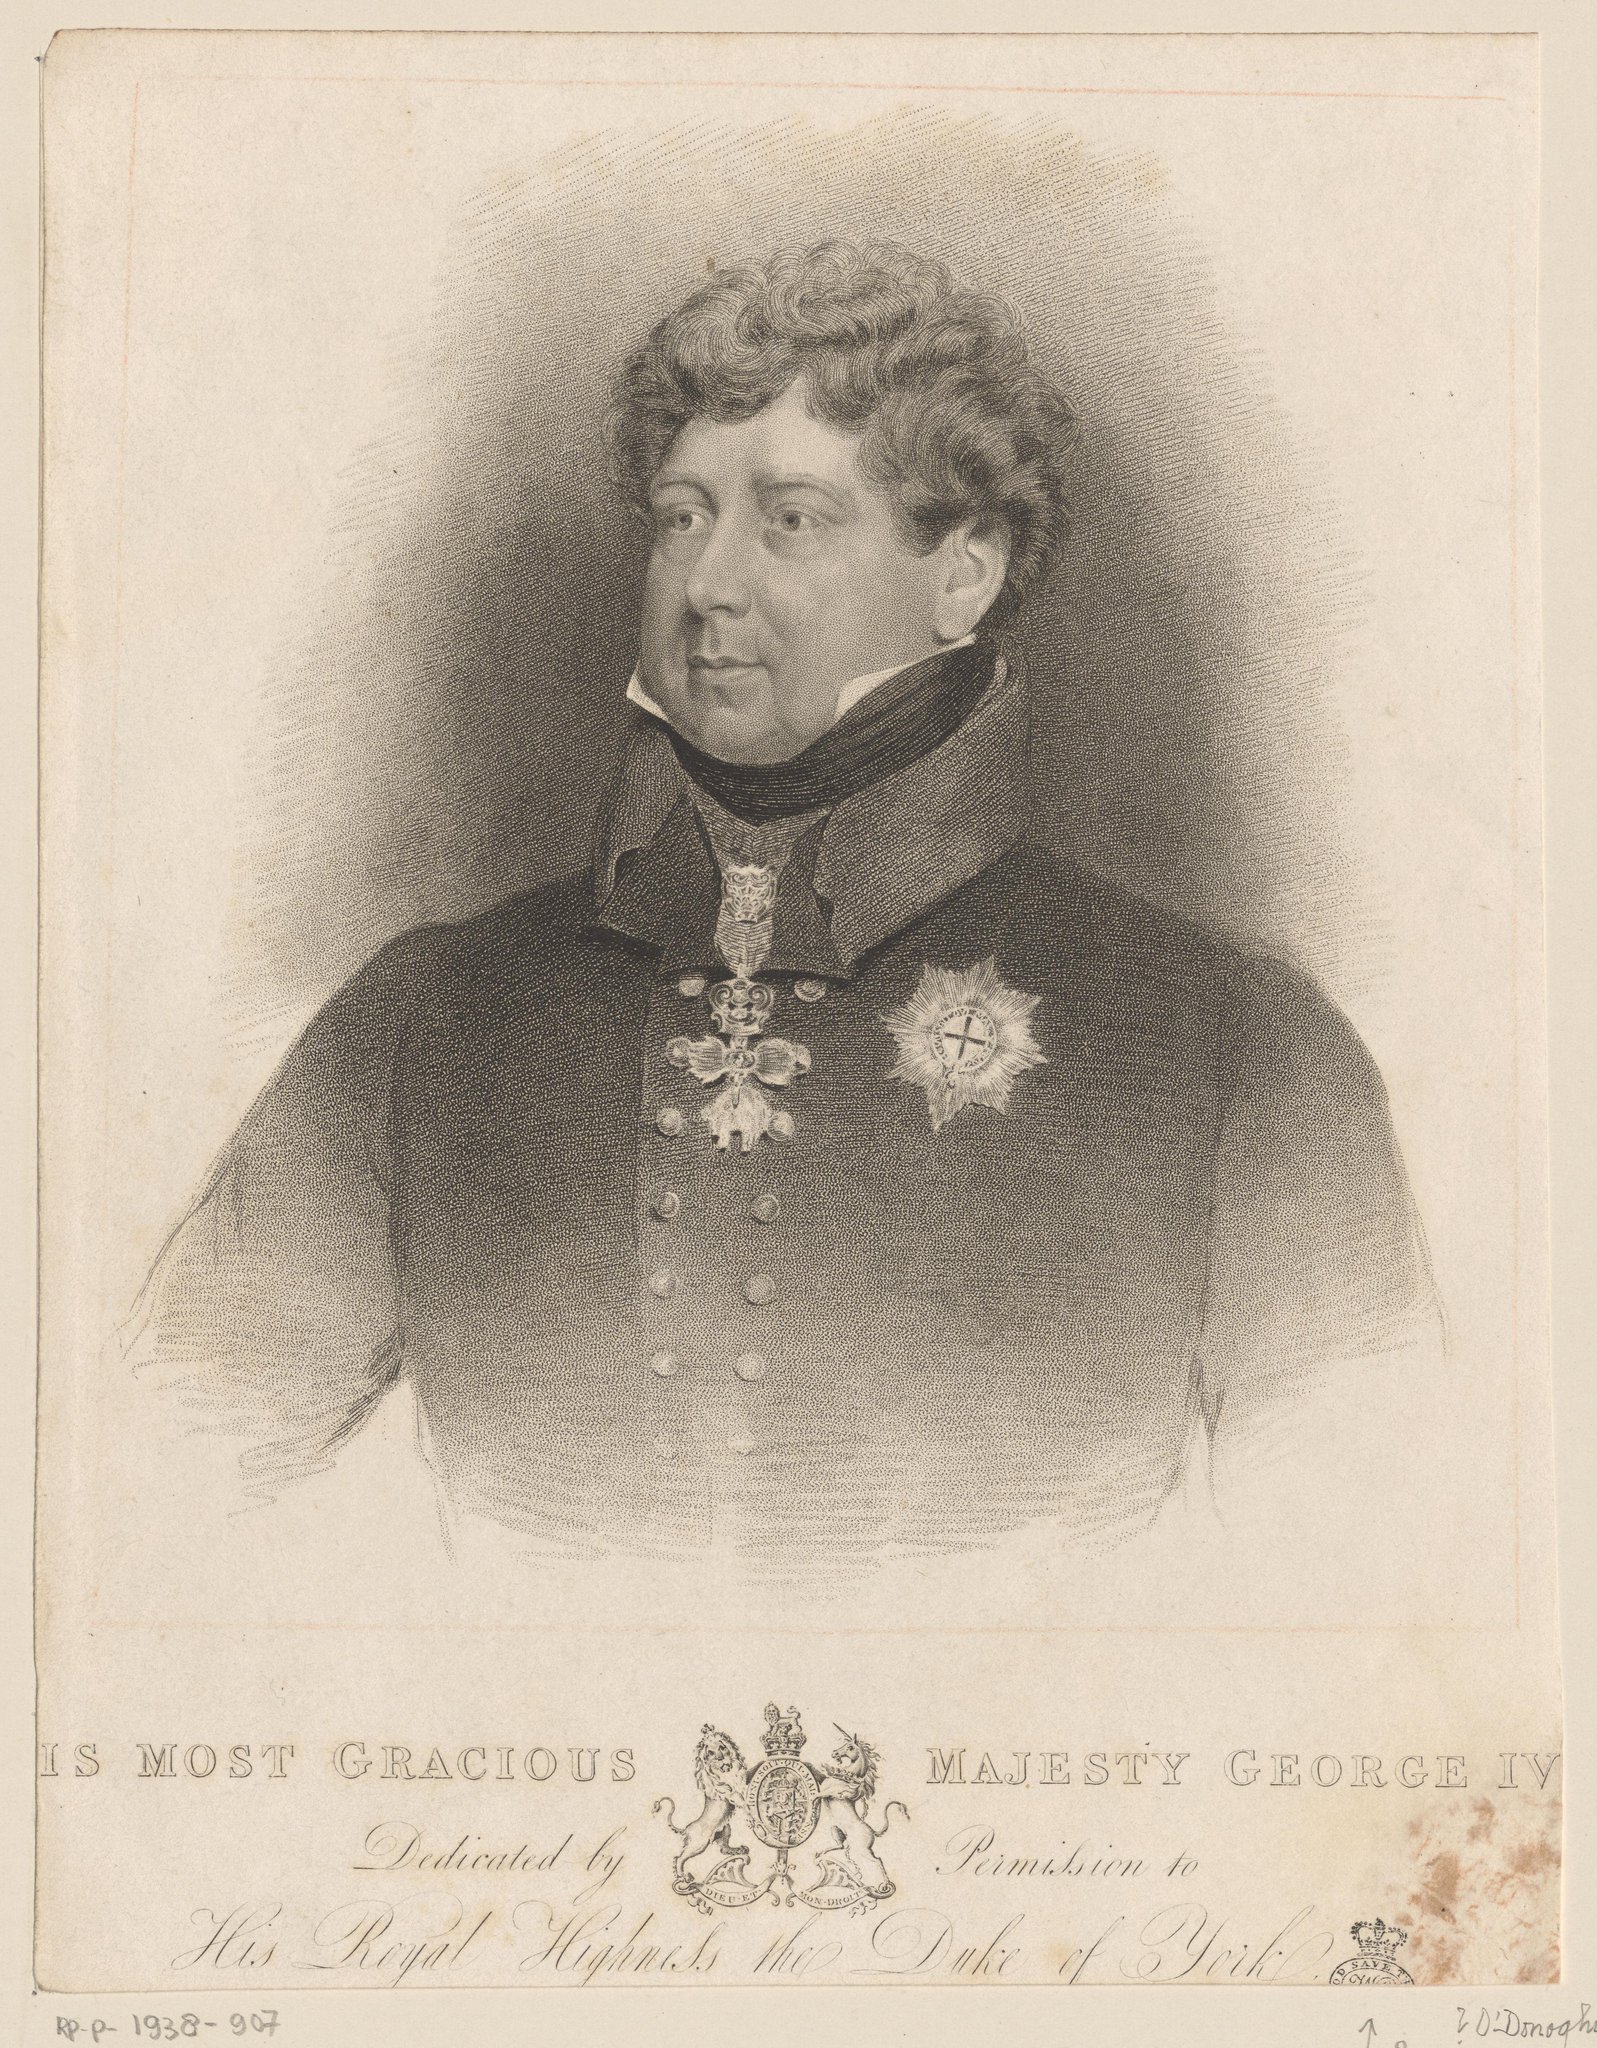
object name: print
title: Portret van George IV, koning van het Verenigd Koninkrijk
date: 1823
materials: paper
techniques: engraving, etching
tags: george iv (koning van het verenigd koninkrijk), historical persons, king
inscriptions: collector's mark: Lugt 2228